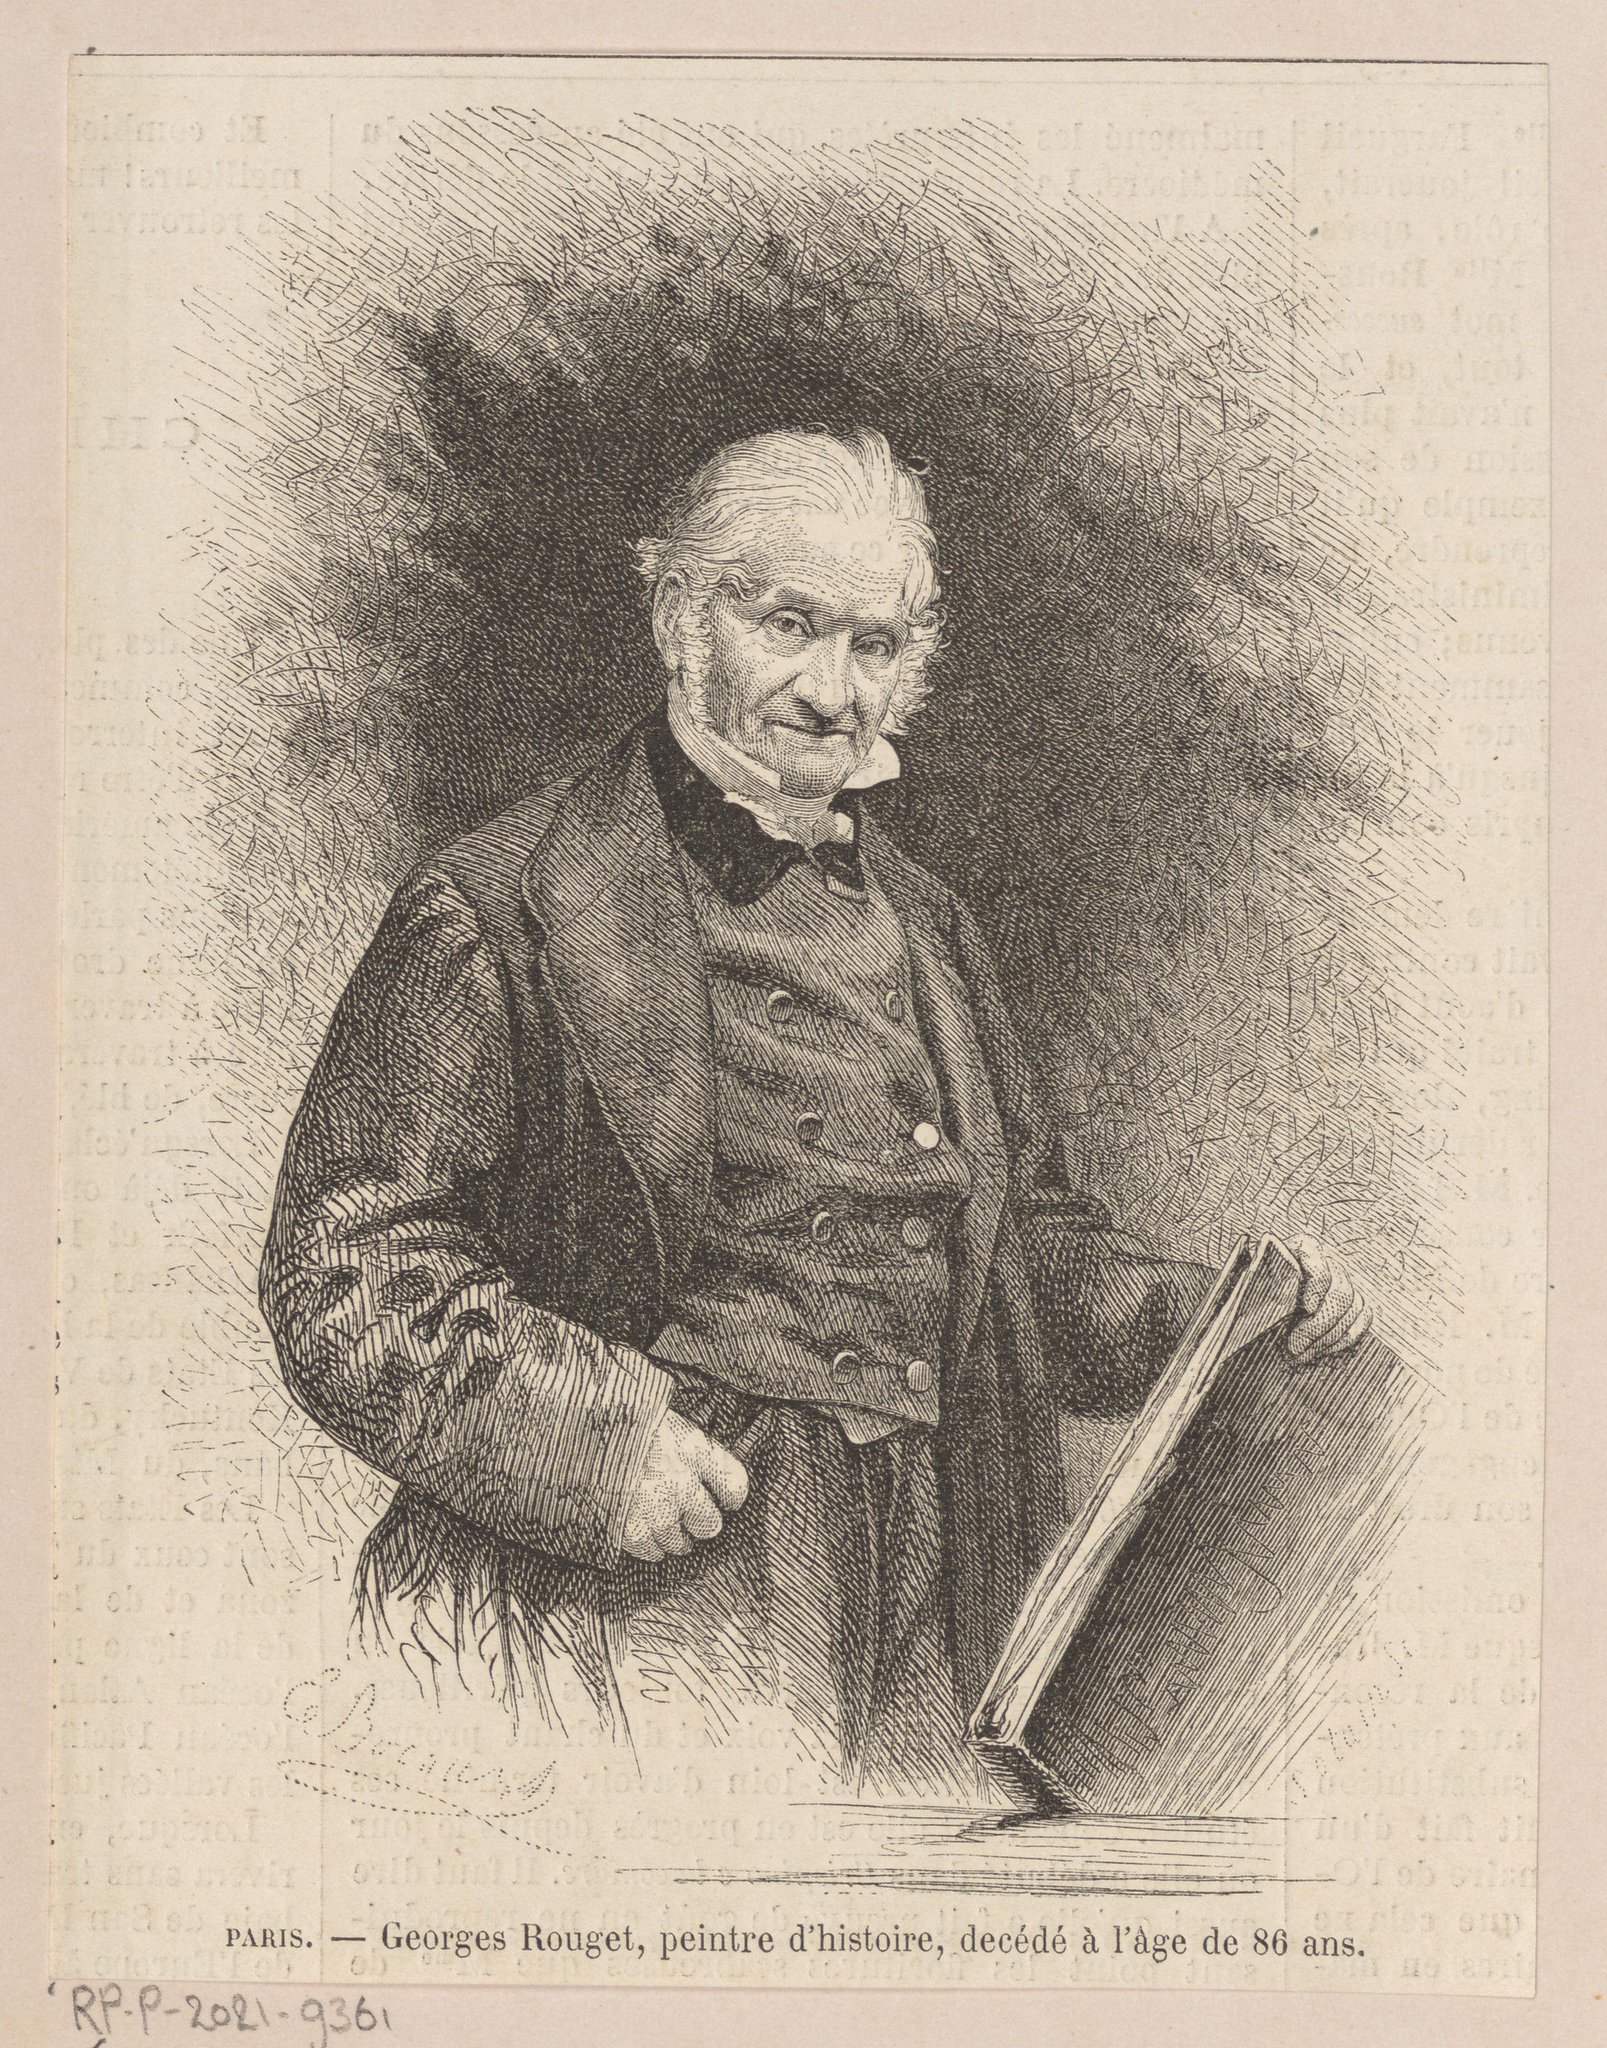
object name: print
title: Portret van Georges Rouget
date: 1869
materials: paper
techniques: letterpress printing, engraving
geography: paris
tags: paris, print maker, georges rouget, historical persons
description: Prent uit: Le monde illustré: journal hebdomadaire 13 (1869), nr. 628, 24 april 1869.